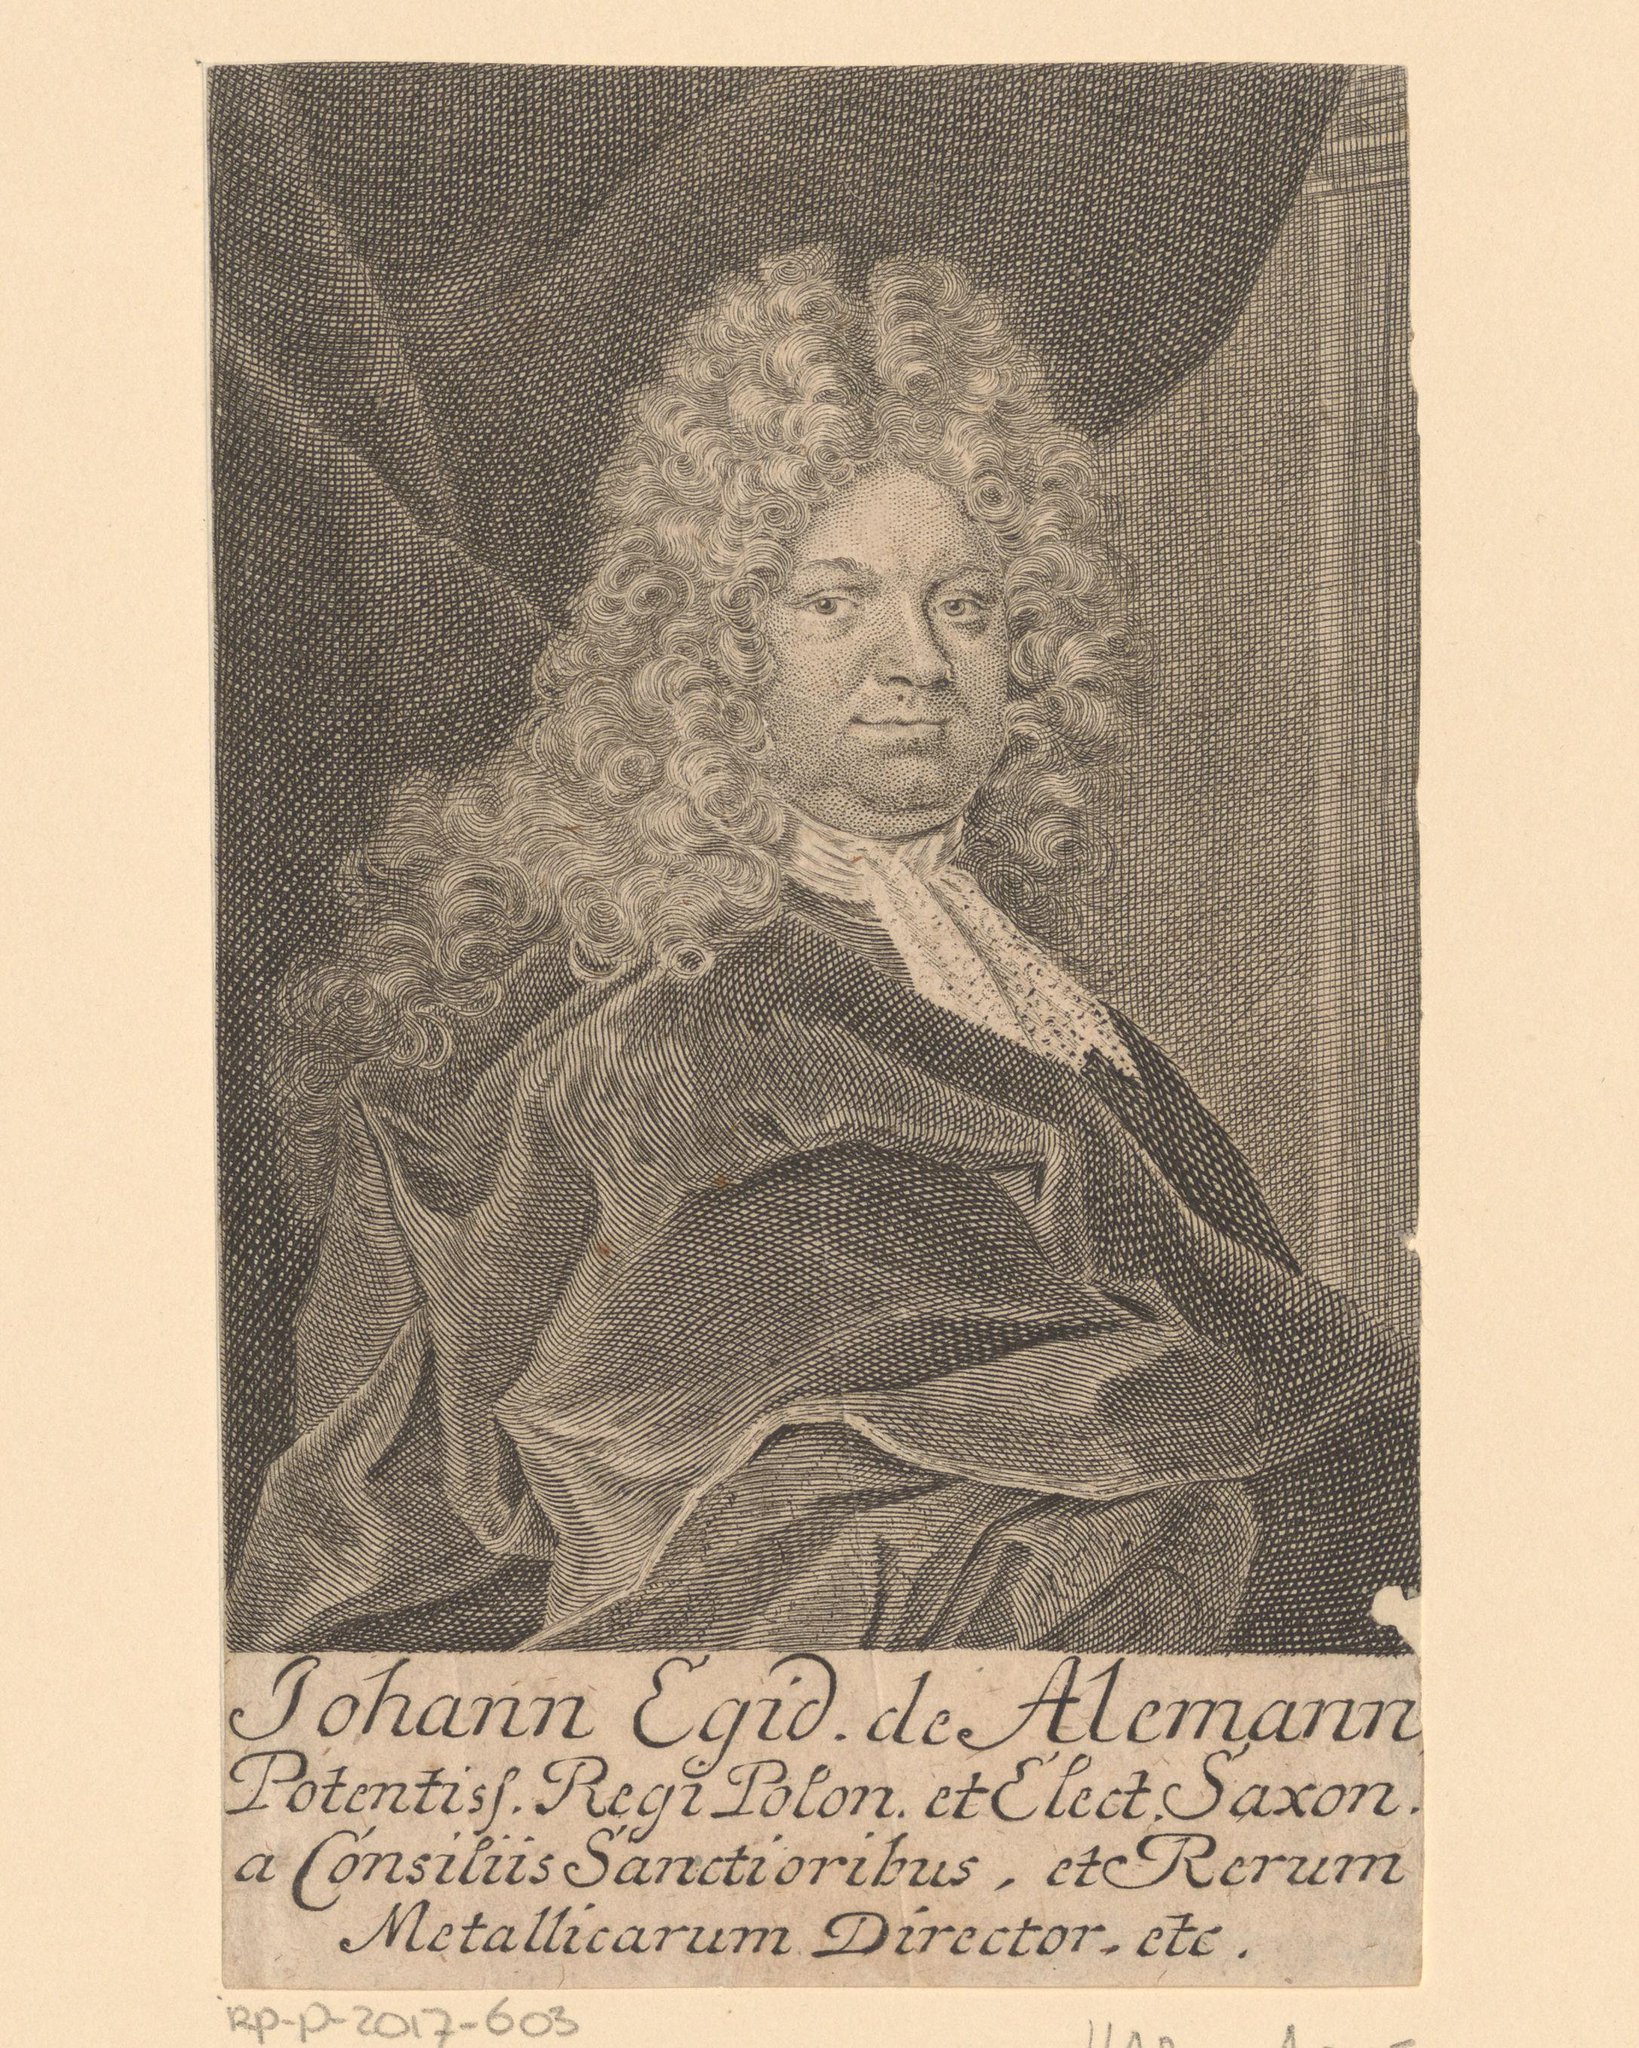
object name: print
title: Portret van Johann Ägidius von Alemann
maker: martin bernigeroth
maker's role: print maker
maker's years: 1670-1733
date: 1680-1733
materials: paper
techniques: engraving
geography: leipzig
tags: jurist, johann alemann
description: Prent gebruikt voor: Die Europäische Fama, Welche den gegenwärtigen Zustand der vornehmsten Höfe entdecket. Leipzig: Gleditsch, 1713, dl. 145.